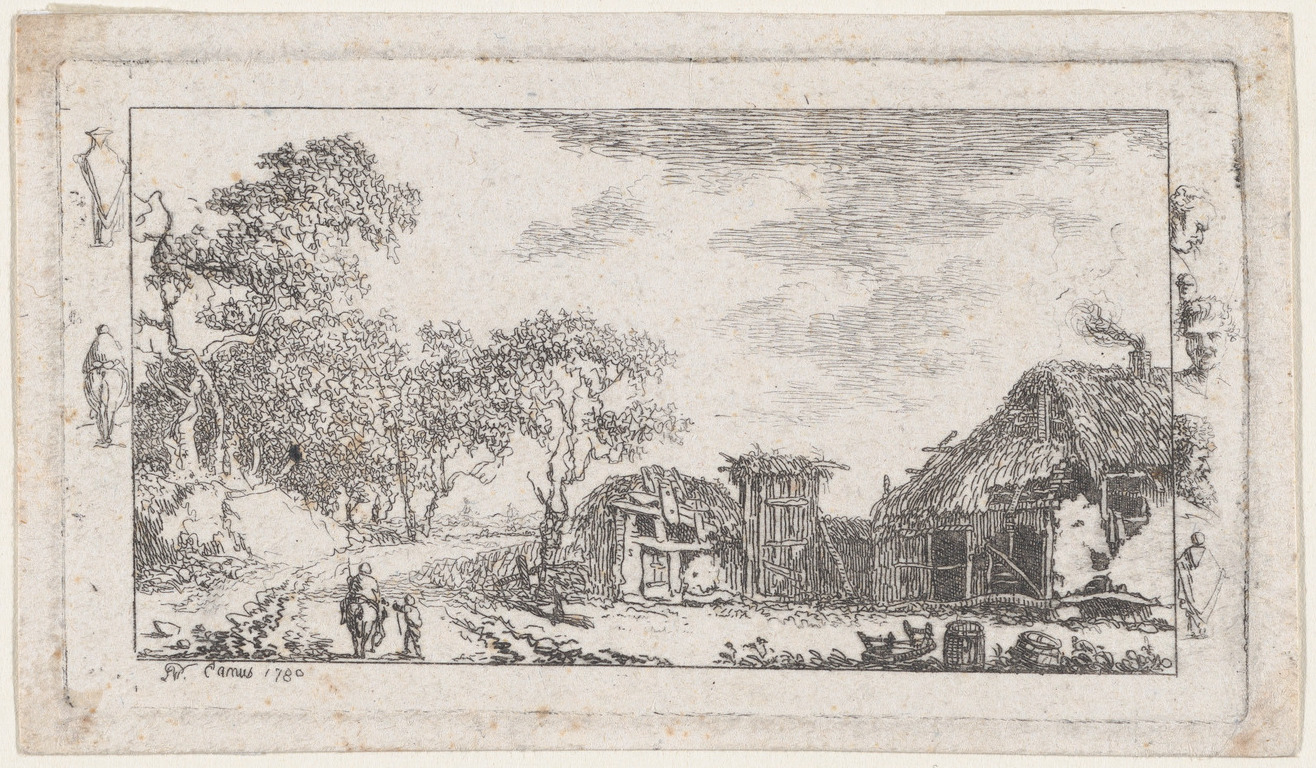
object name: print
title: Landscape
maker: pierre nicholas camus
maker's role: artist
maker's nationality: french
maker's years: 1779-1780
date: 1780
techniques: etching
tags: villages,landscapes